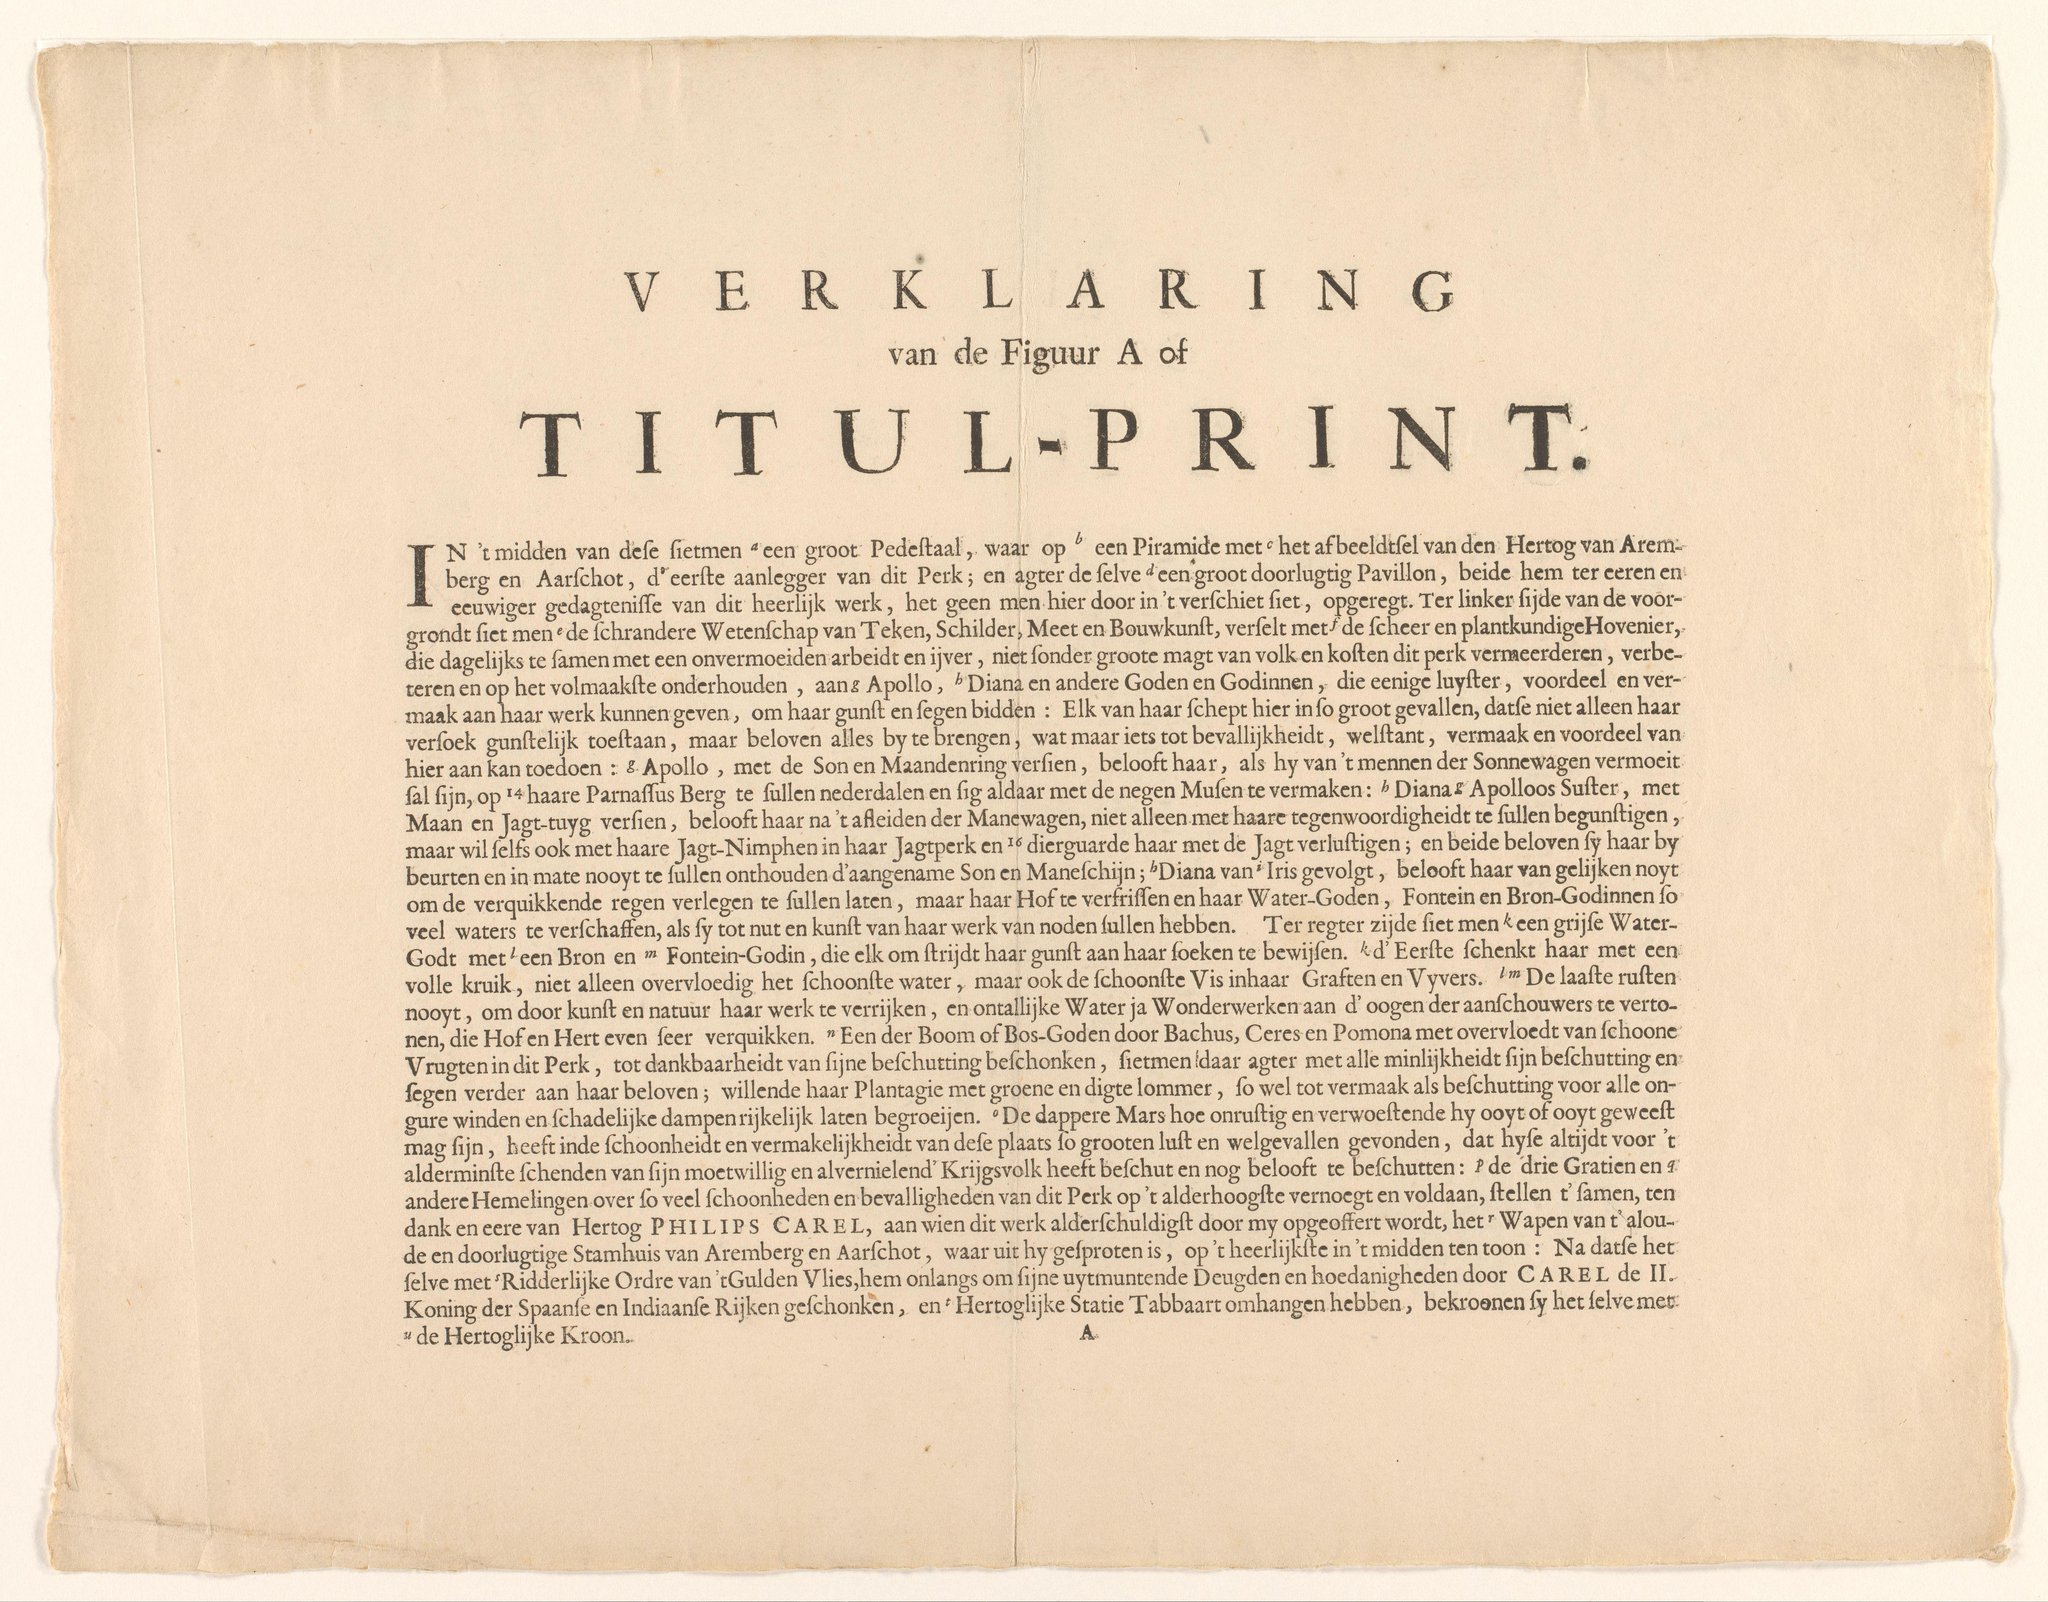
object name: text sheet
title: Het park van Enghien (Edingen)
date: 1685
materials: paper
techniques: letterpress printing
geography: northern netherlands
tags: earl, filips karel van arenberg (hertog van aarschot), public gardens, park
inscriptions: collector's mark: Lugt 2228